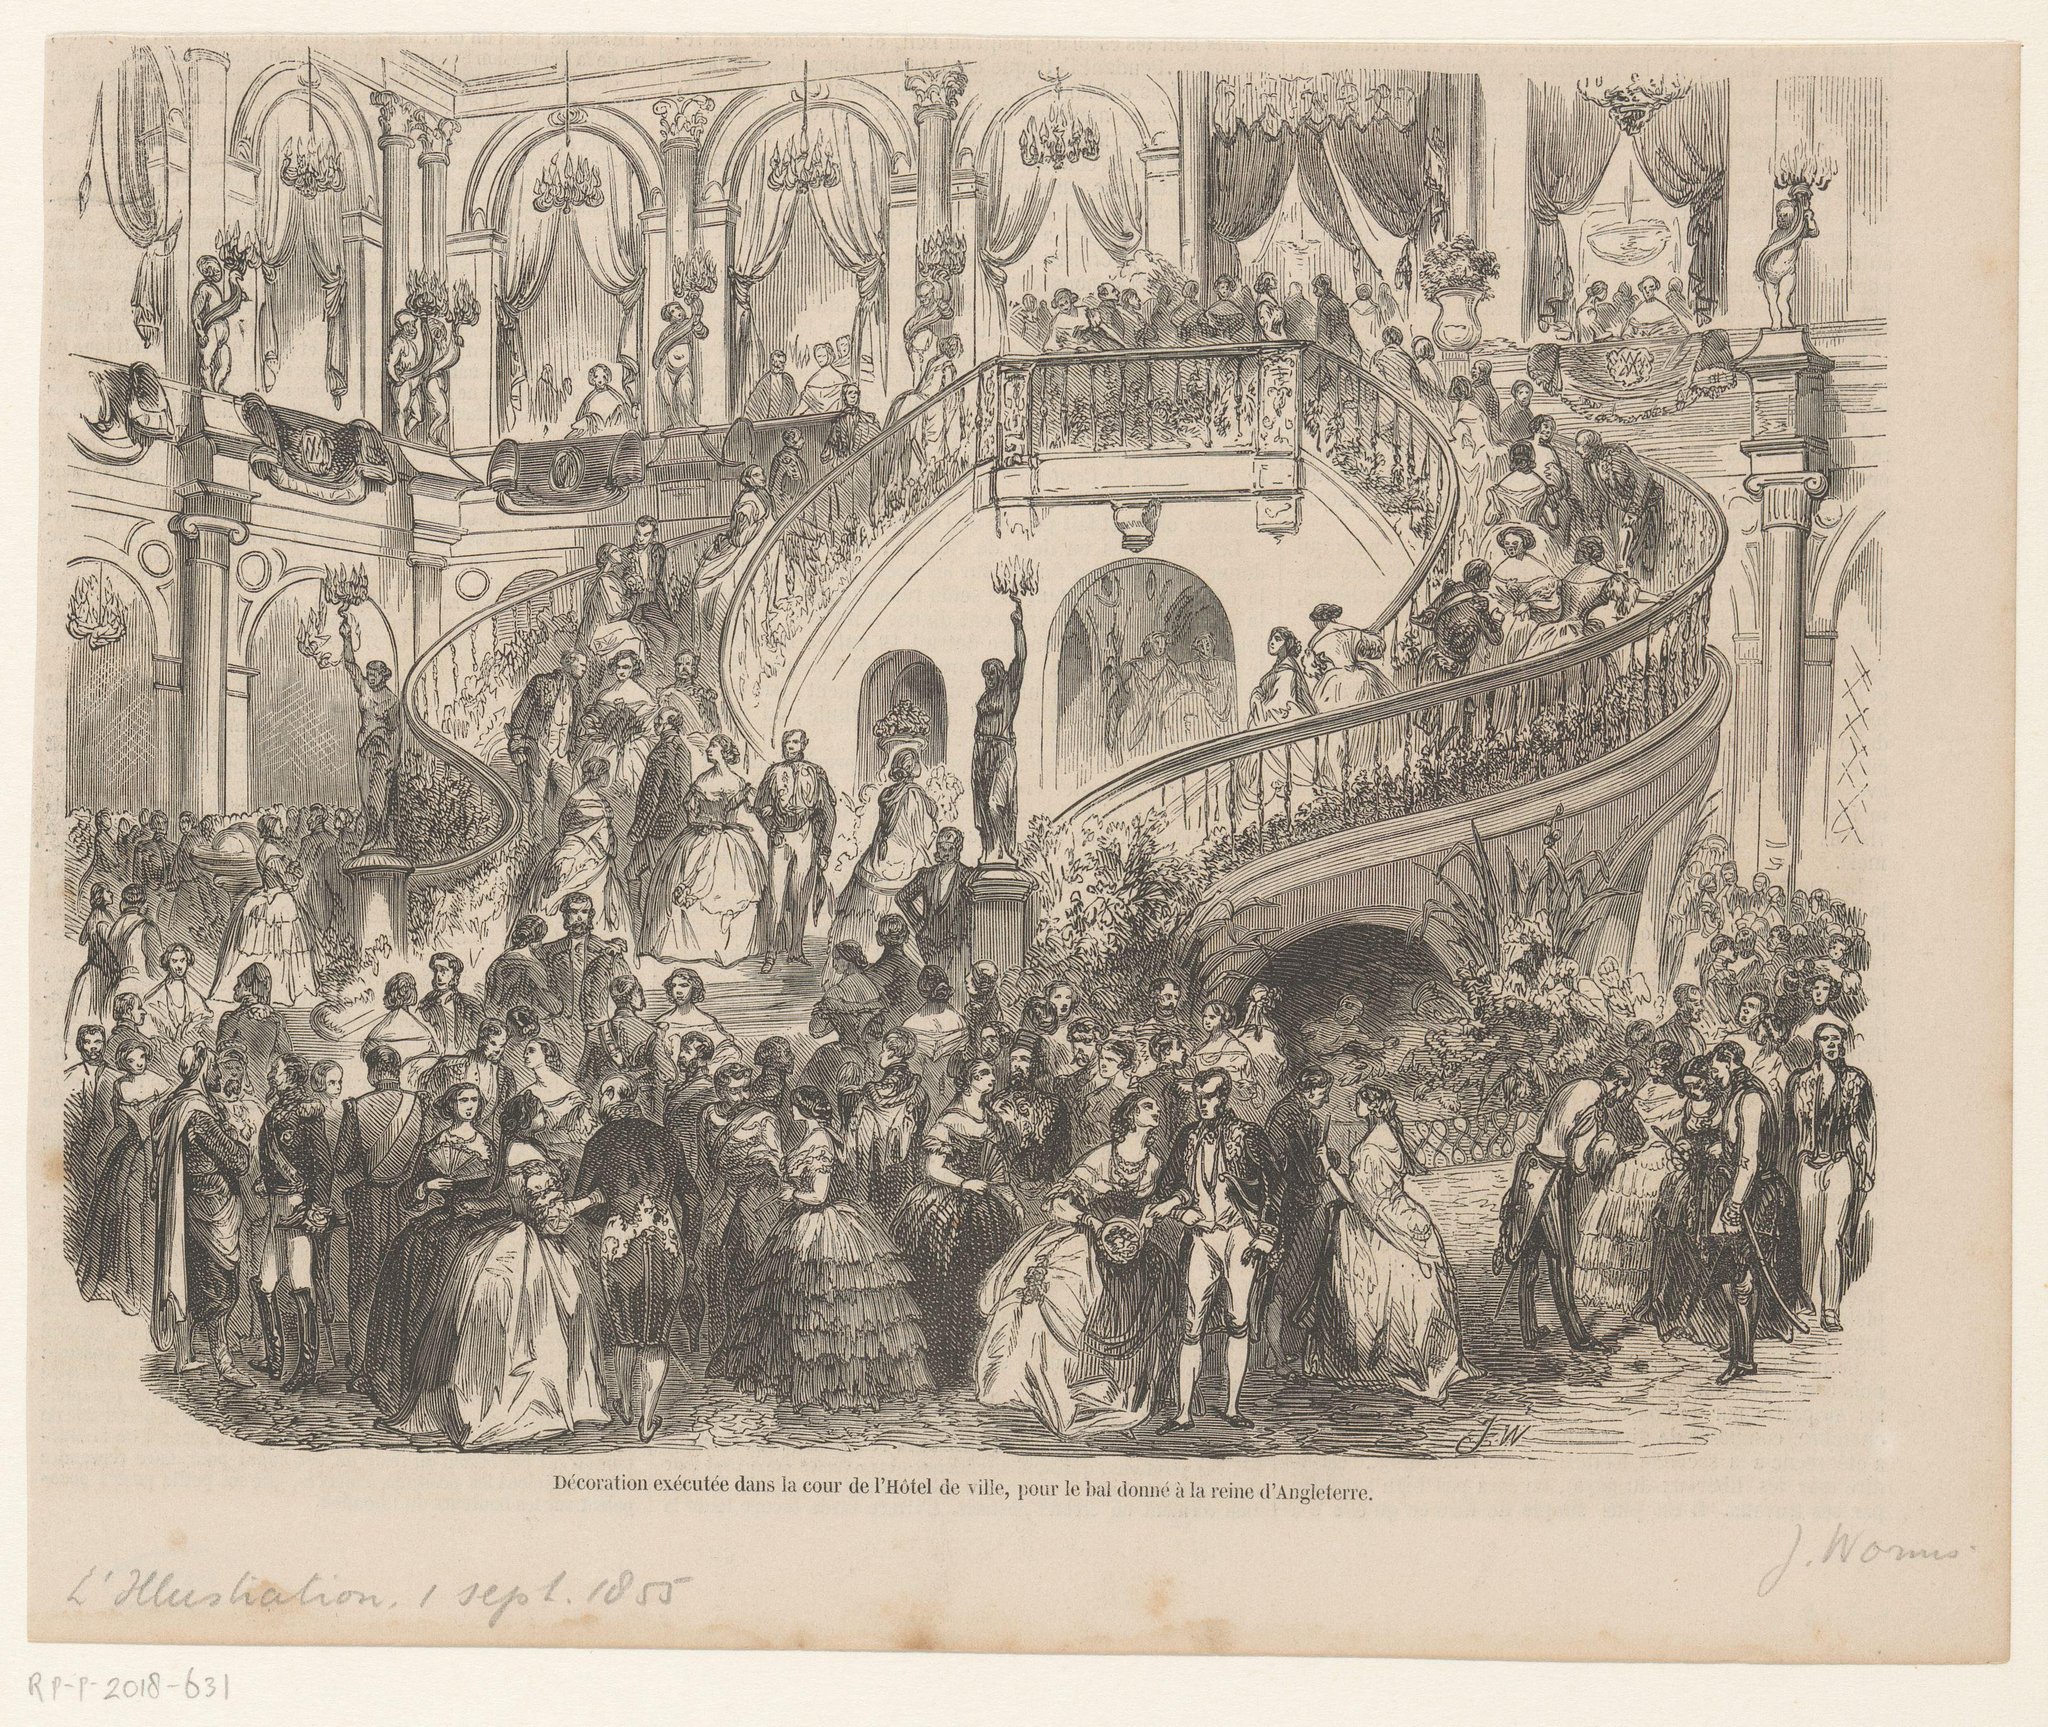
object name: book illustration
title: Décoration exécutée dans la cour de l'Hôtel de ville, pour le bal donné à la reine d'Angleterre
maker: jules worms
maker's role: painter, print maker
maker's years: 1832-1924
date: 1855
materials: paper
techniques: engraving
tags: victoria (koningin van het verenigd koninkrijk en keizerin van india), paris, london, napoleon iii (keizer der fransen), public festivities at other royal events, not meant or mentioned above, ball, formal dance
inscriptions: collector's mark: Lugt 2228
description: Het koninklijk bezoek van de Britse koningin Victoria aan Napoleon III (17-28 augustus 1855). Versieringen in het Hôtel de Ville te Parijs voor het bal ter ere van koningin Victoria, augustus 1855.